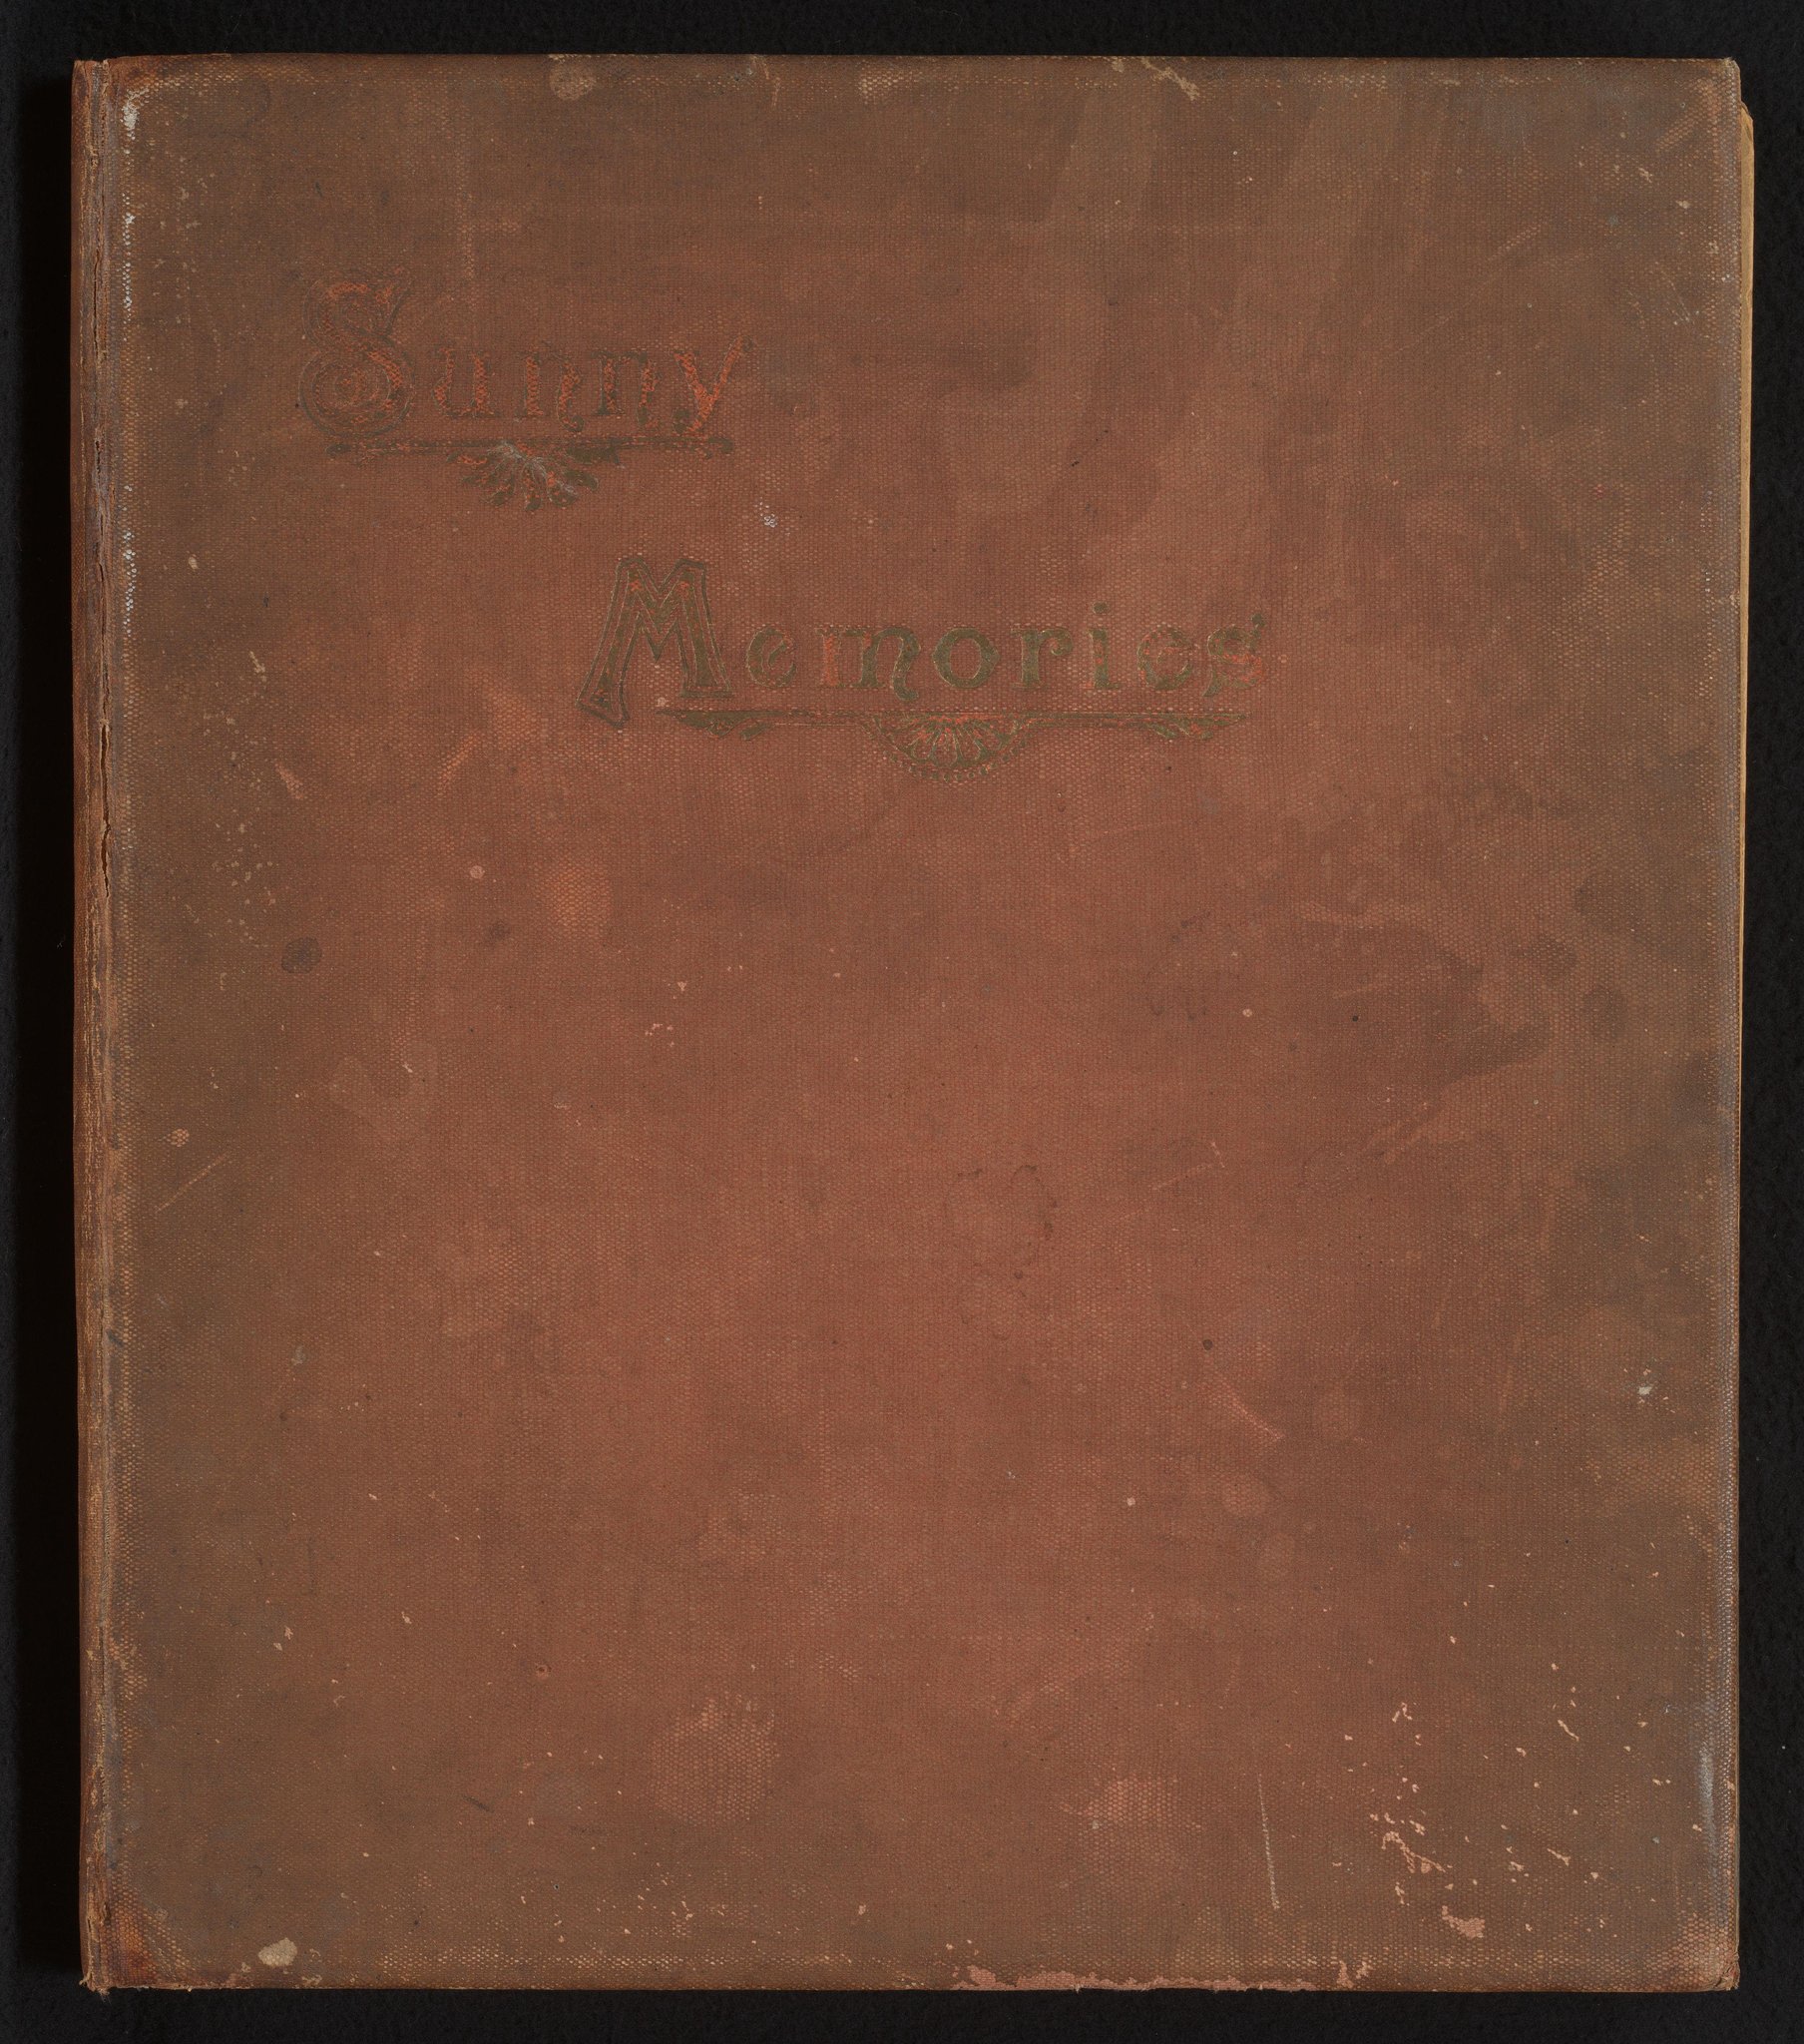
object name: slip in album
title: Fotoalbum met 137 foto's, gemaakt in Nederland, Noorwegen en Spitsbergen tijdens een reis met de S.Y. Sapphire, 22 juni tot 6 augustus 1901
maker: Anonymous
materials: paper, cardboard, ink, textile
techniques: pen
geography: great britain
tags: j. tooth, f. green (fotograaf), duchess of bedford, i. marshall, london, politician, mary russell, netherlands, norway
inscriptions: number: ‘5’, stamp: ‘L d H’, inscription: ‘Holland, Norway and Spitsbergen in the S.Y. Sapphire. June 22nd to Aug:st 6th, 1901’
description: Insteekalbum met 20 pagina's en 137 foto's van een reis naar Marken, Noorwegen en Spitsbergen op de S.Y. Sapphire. De eerste twee foto's zijn op de binnenzijde van het voorplat geplakt. Het reisgezelschap bestaat uit de Duke of Bedford [=Herbrand Arthur Russell, 11th Duke of Bedford, 1858-1940], Mr. Findlay, Miss Marshall, Miss Tooth, Miss Russell, Lord Tavistock [=Hastings Russell, oudste zoon van de Duke of Bedford], Miss Green, Duchess of Bedford [=Mary du Caurroy Tribe]. Vrijwel alle mensen in deze groep fotografeerden. Met initialen boven de foto's is duidelijk gemaakt wie wat maakte. Vrijwel alle foto's hebben handgeschreven bijschriften, waarbij het soms gaat om citaten uit gedichten en toneelstukken.